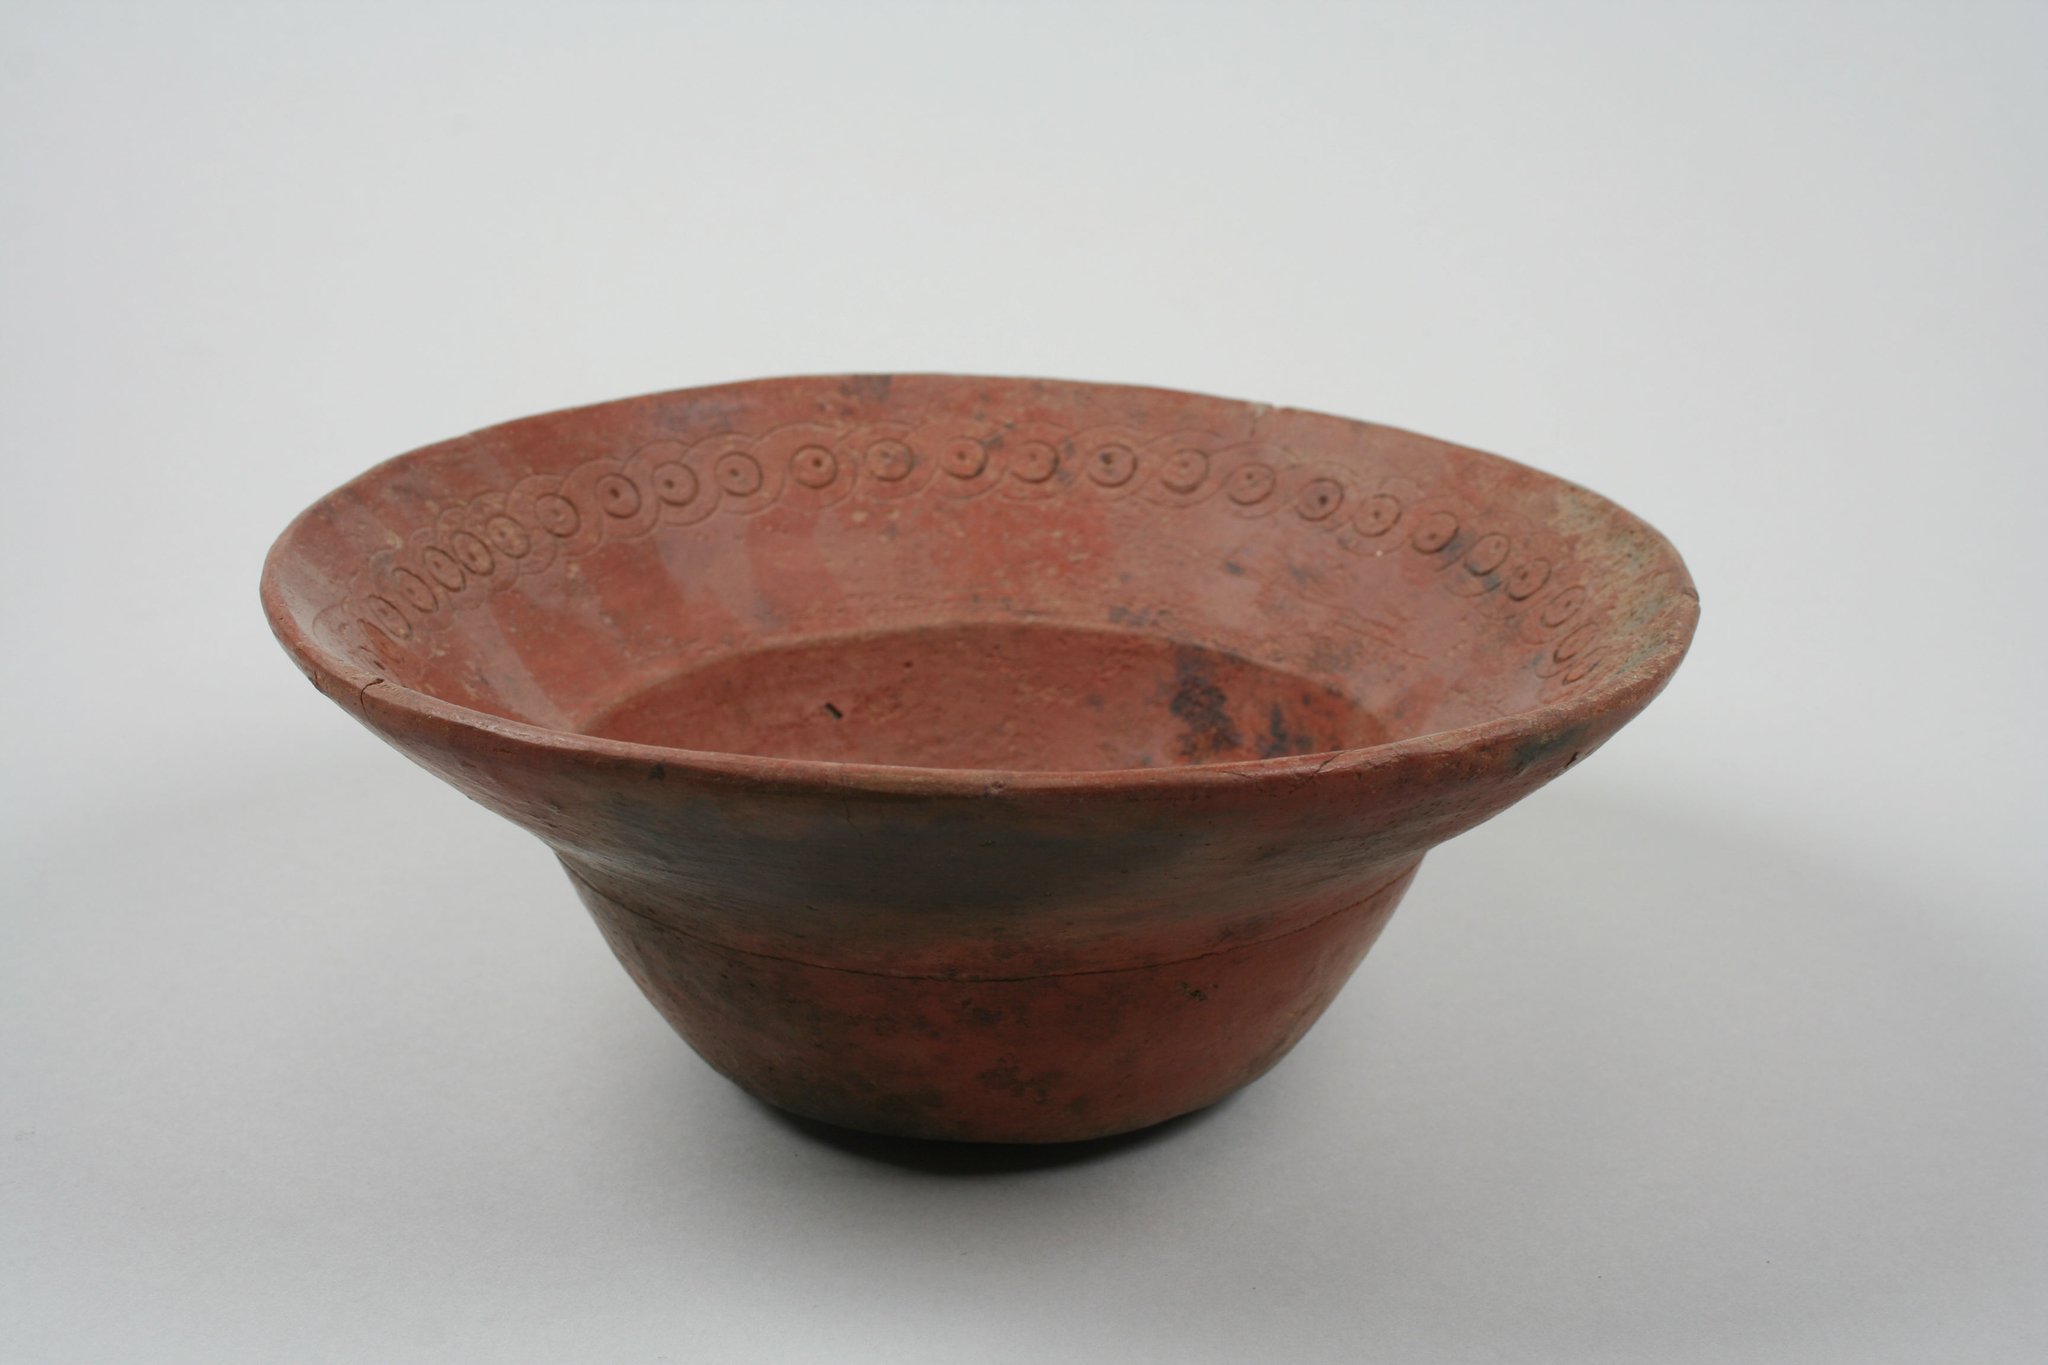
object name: bowl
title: Bowl with Figure Eight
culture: paracas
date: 700-301 BCE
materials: ceramic, pigment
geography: peru